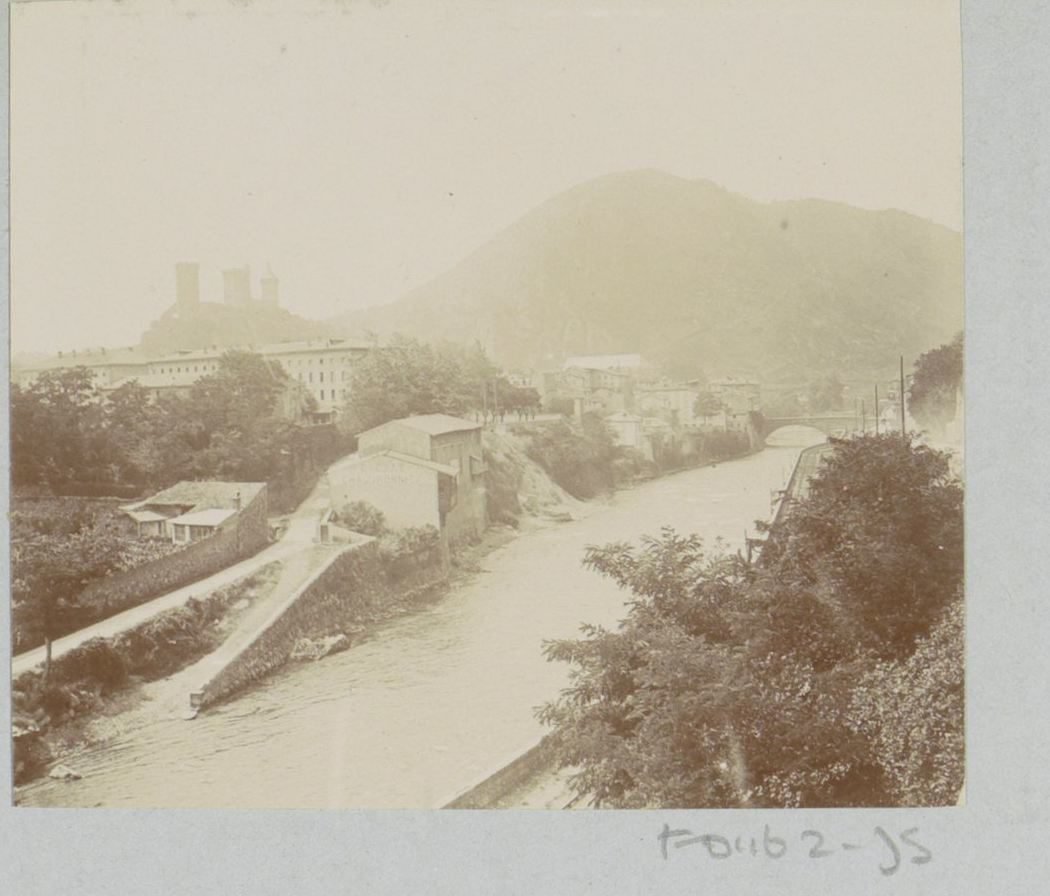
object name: photograph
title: Gezicht op Foix met links een kasteel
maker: Anonymous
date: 1905-1910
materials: paper, photographic support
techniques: gelatin silver print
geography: foix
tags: prospect of village, silhouette of village, castle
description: Onderdeel van Fotoalbum van een Franse amateurfotograaf met bezienswaardigheden in Frankrijk, Zwitserland en Italië.